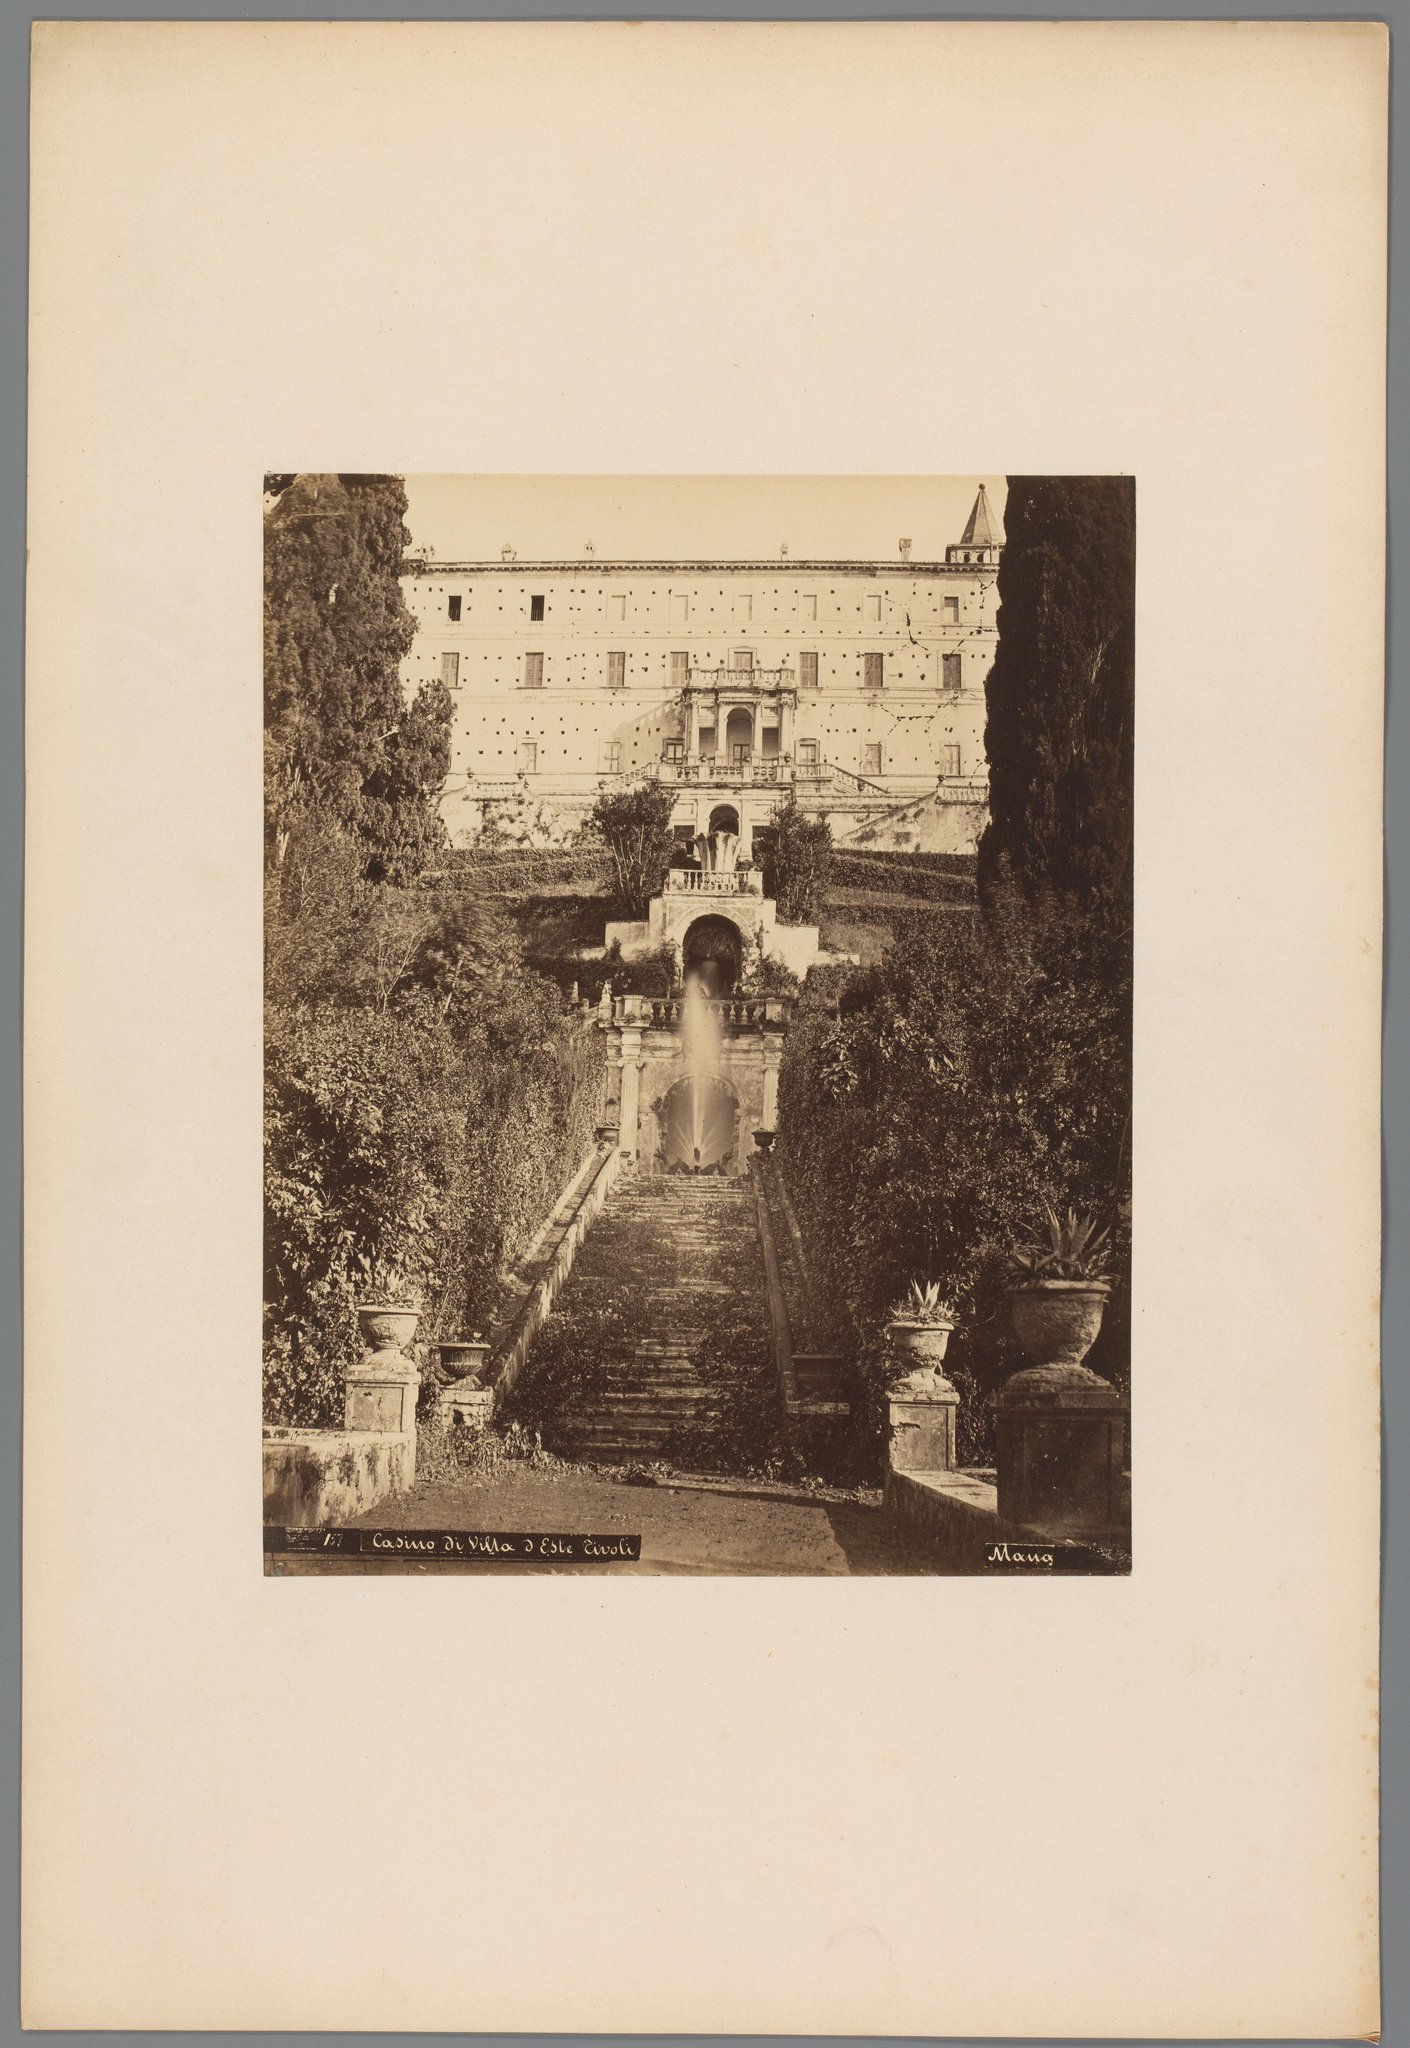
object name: photograph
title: Trappen naar Villa d'Este te Tivoli, Italië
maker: michèle mang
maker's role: fotograaf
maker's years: 1840-1909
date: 1863-1887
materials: cardboard, paper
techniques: albumen print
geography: tivoli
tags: garden fountain, palace, front steps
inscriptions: number: ‘157’